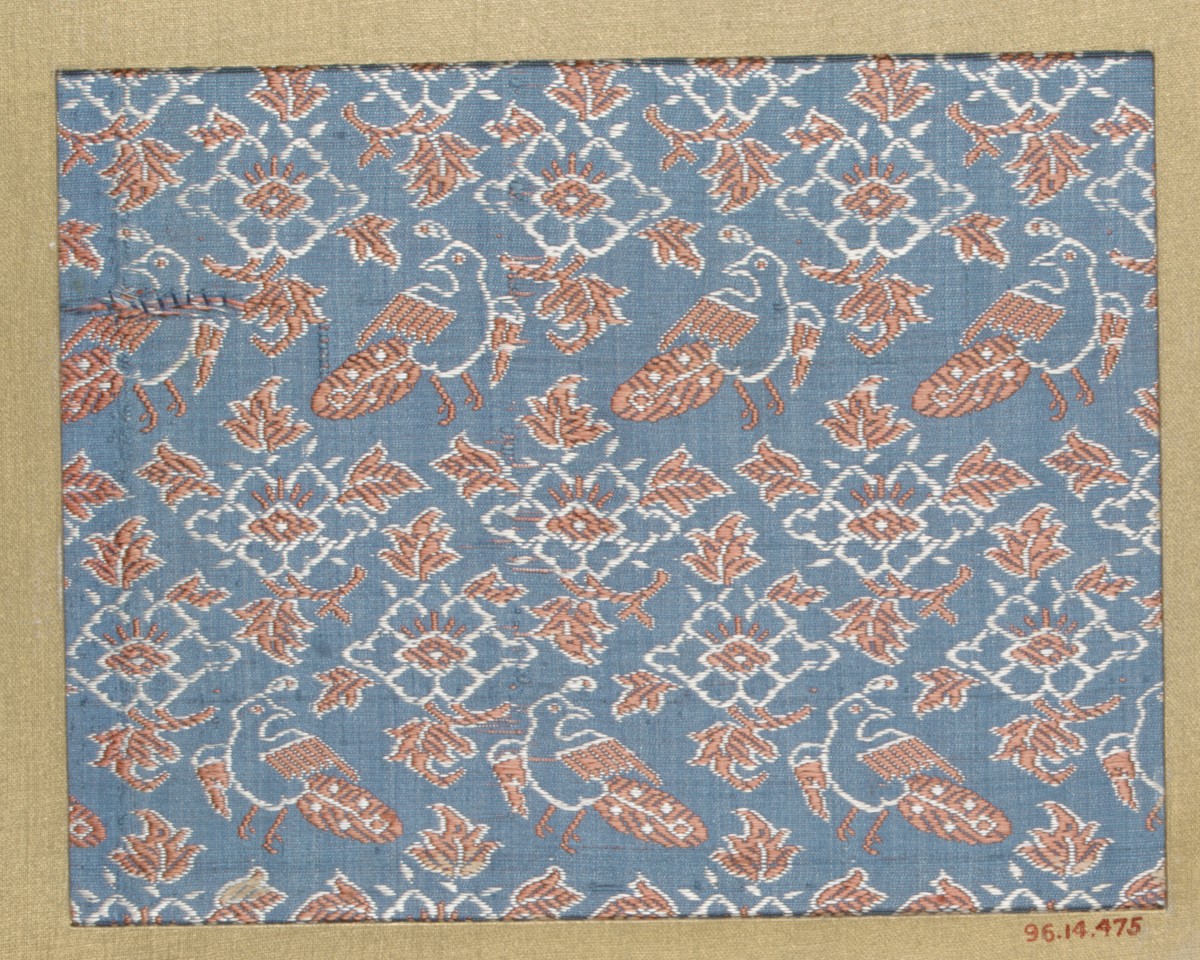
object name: piece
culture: japanese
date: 1701-1900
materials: silk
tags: flowers,leaves